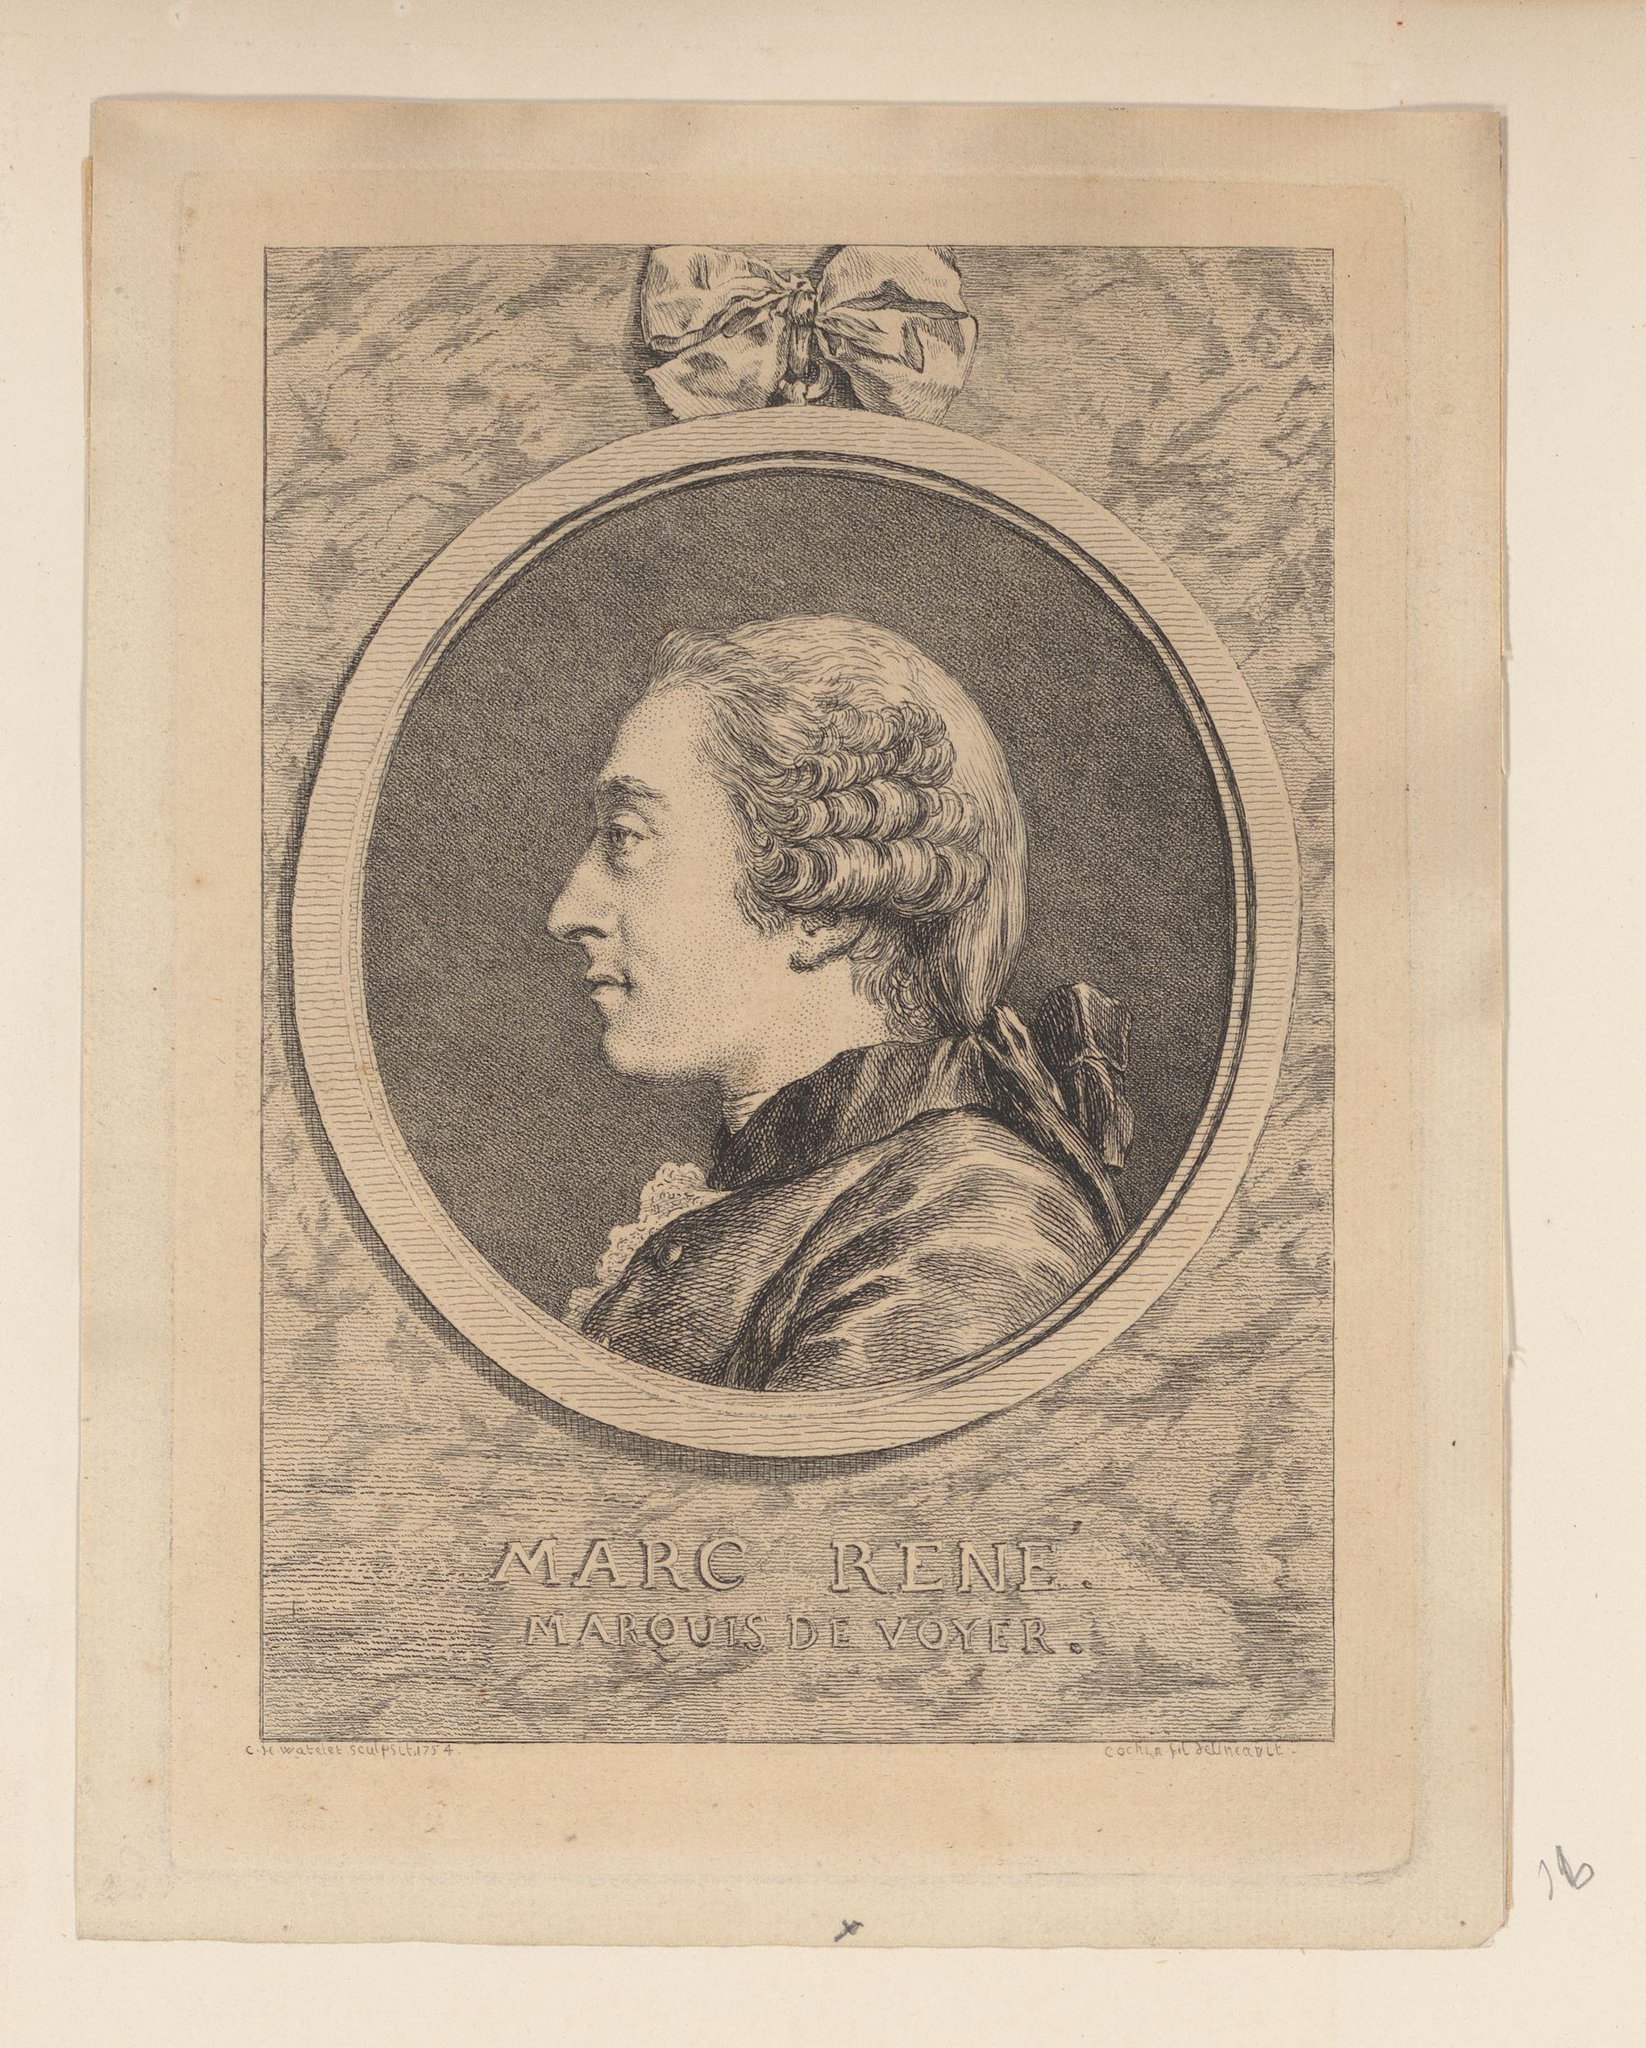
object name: album leaf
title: Marc René Marquis de Voyer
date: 1754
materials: paper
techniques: engraving, etching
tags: paris, marc rené voyer de paulmy d’argenson (marquis de), ranks in the army, historical persons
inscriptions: date